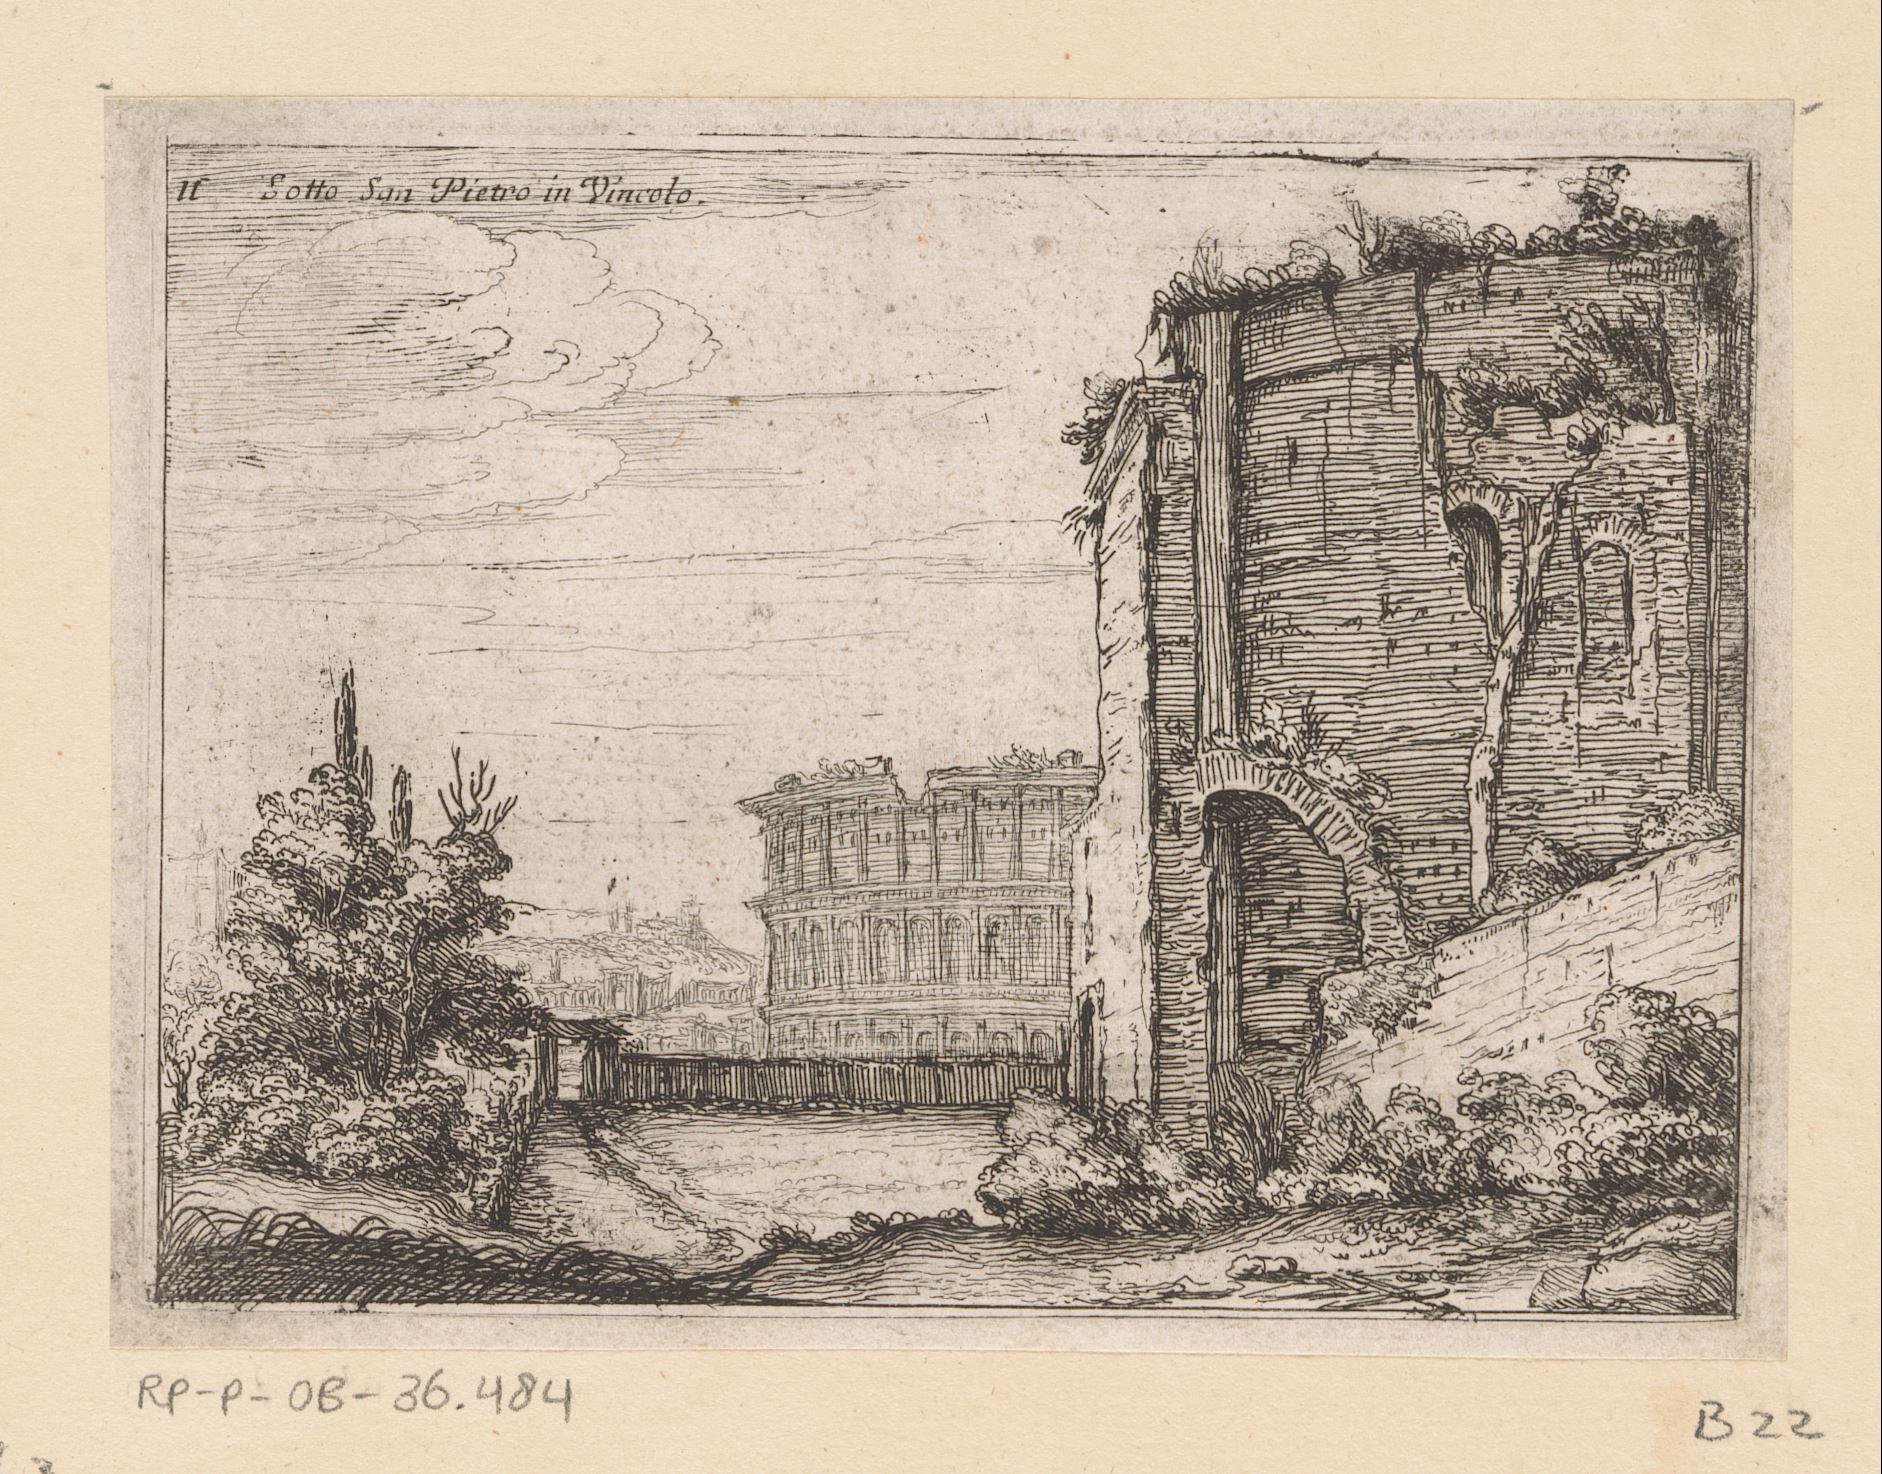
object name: print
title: Sotto San Pietro in Vincolo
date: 1629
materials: paper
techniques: etching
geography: tuscany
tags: landscape with ruins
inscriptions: collector's mark: Lugt 2228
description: Gezicht op het Colosseum vanaf de San Pietro in Vincoli te Rome. Rechts de resten van mogelijk de Thermen van Titus.